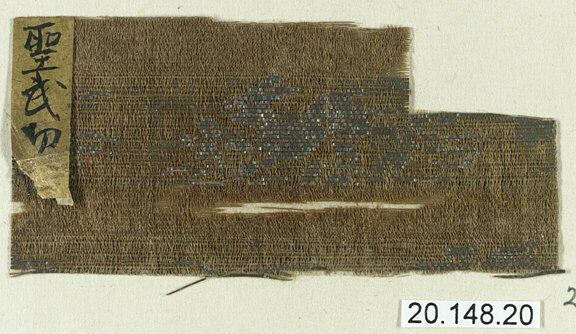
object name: piece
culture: japanese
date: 1101-1200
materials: silk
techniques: compound weave